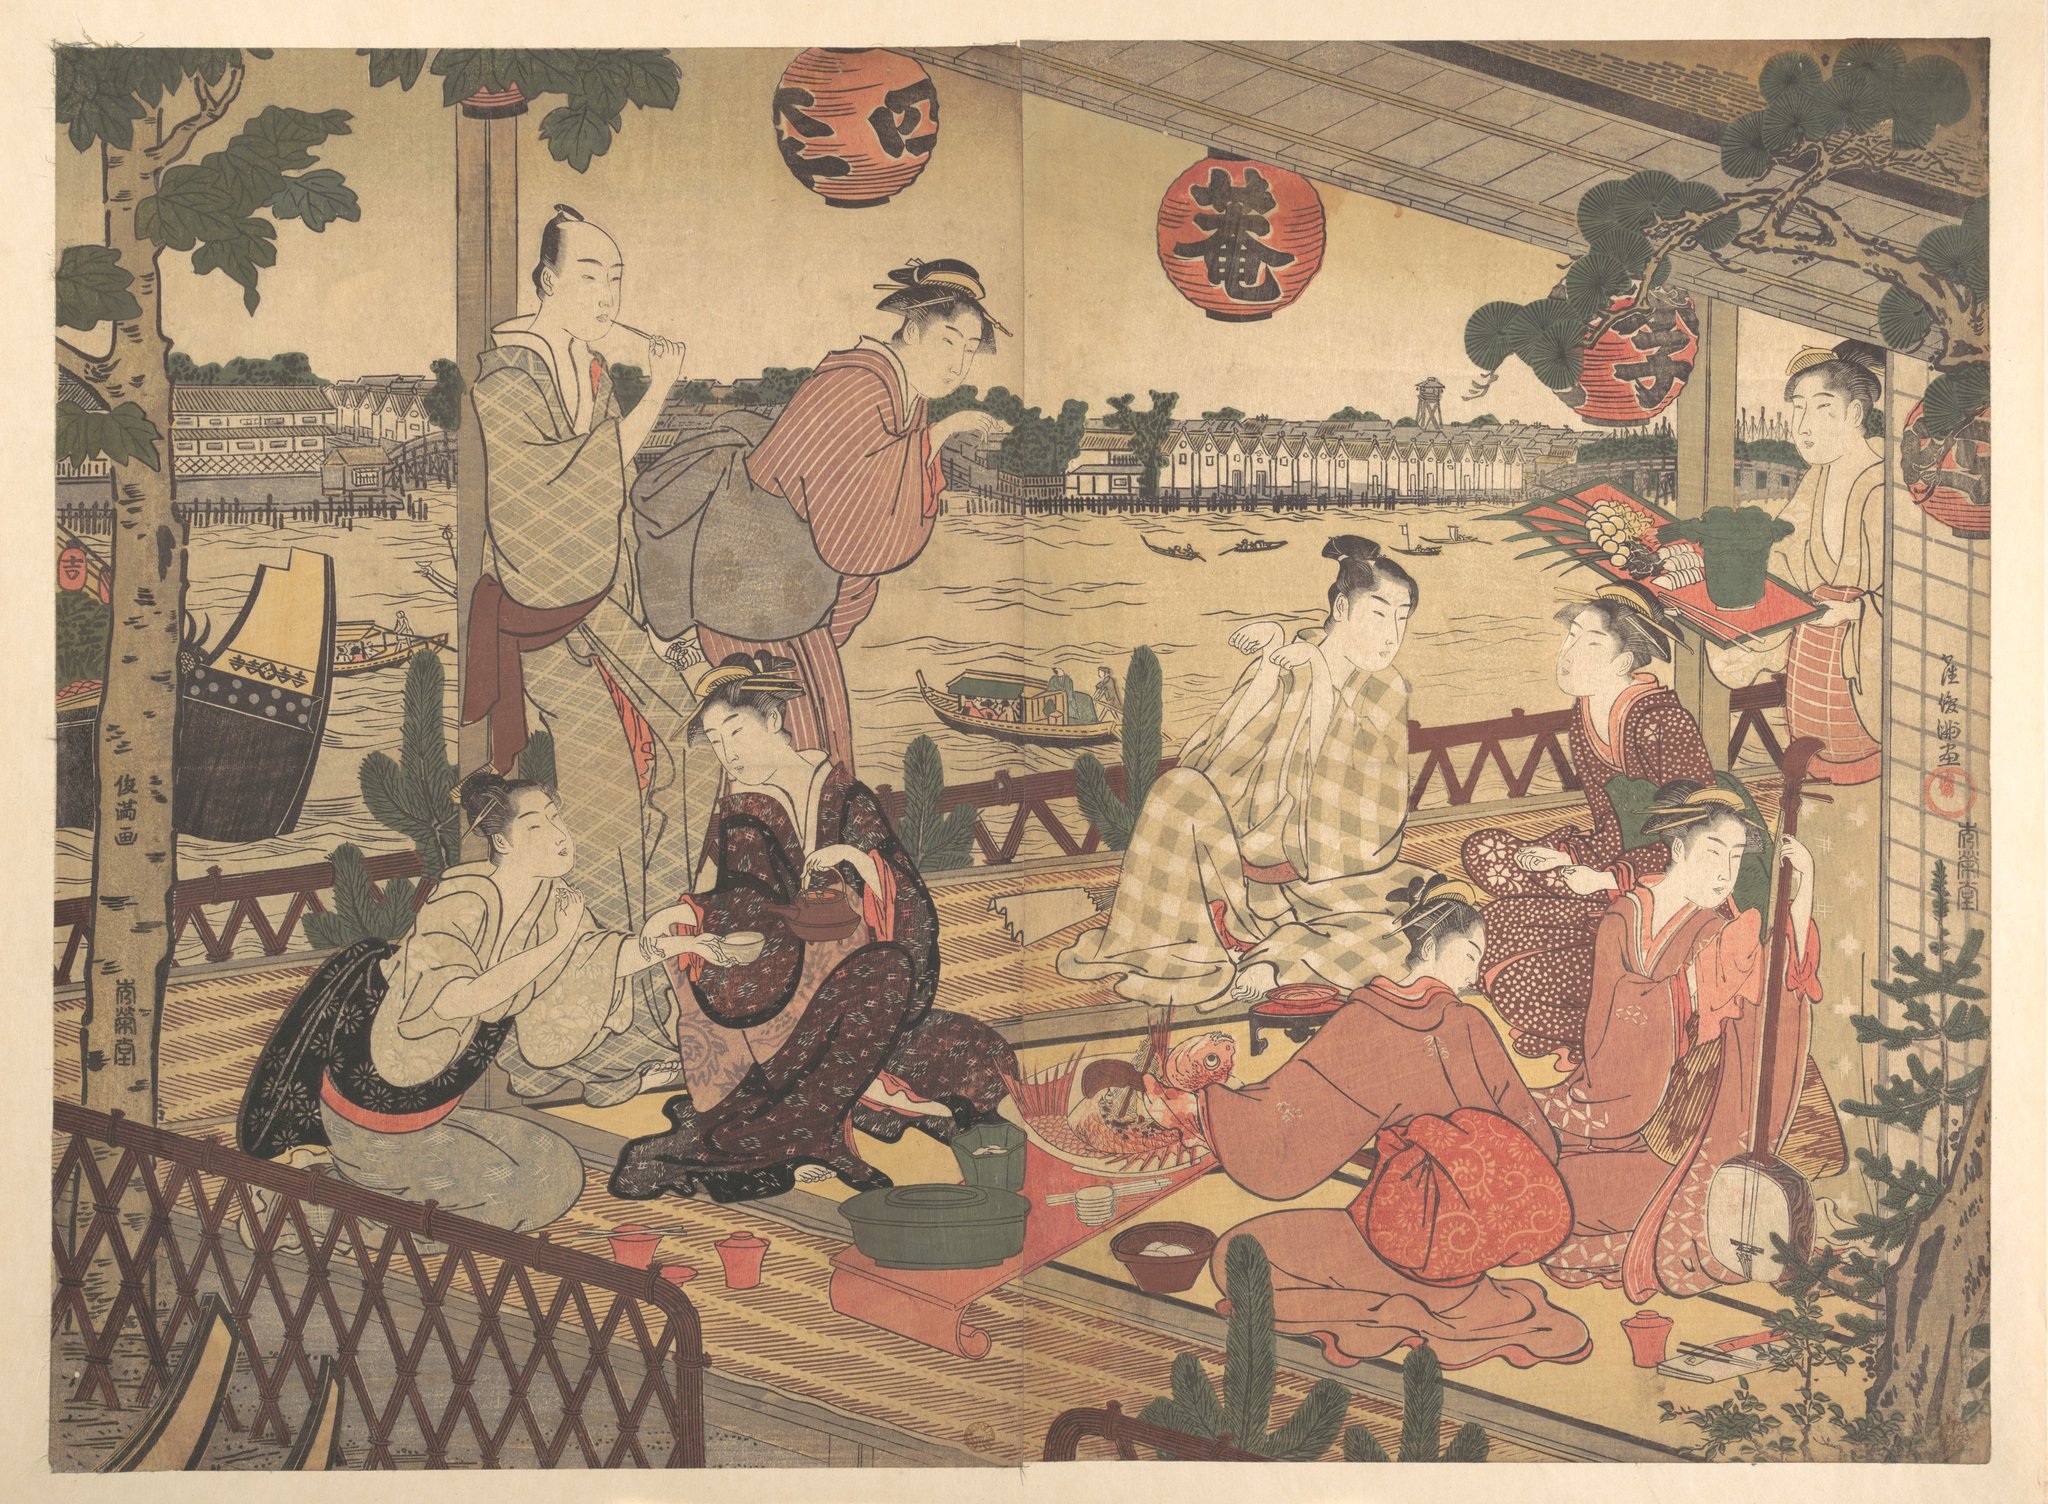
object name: print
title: Two Young Men and Several Women Dining at a Tea-house on the Bank of the Sumida River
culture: japanese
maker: kubo shunman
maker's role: artist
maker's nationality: japanese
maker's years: 1757-1820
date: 1788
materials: ink, paper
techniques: woodblock print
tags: men,women,rivers,dining